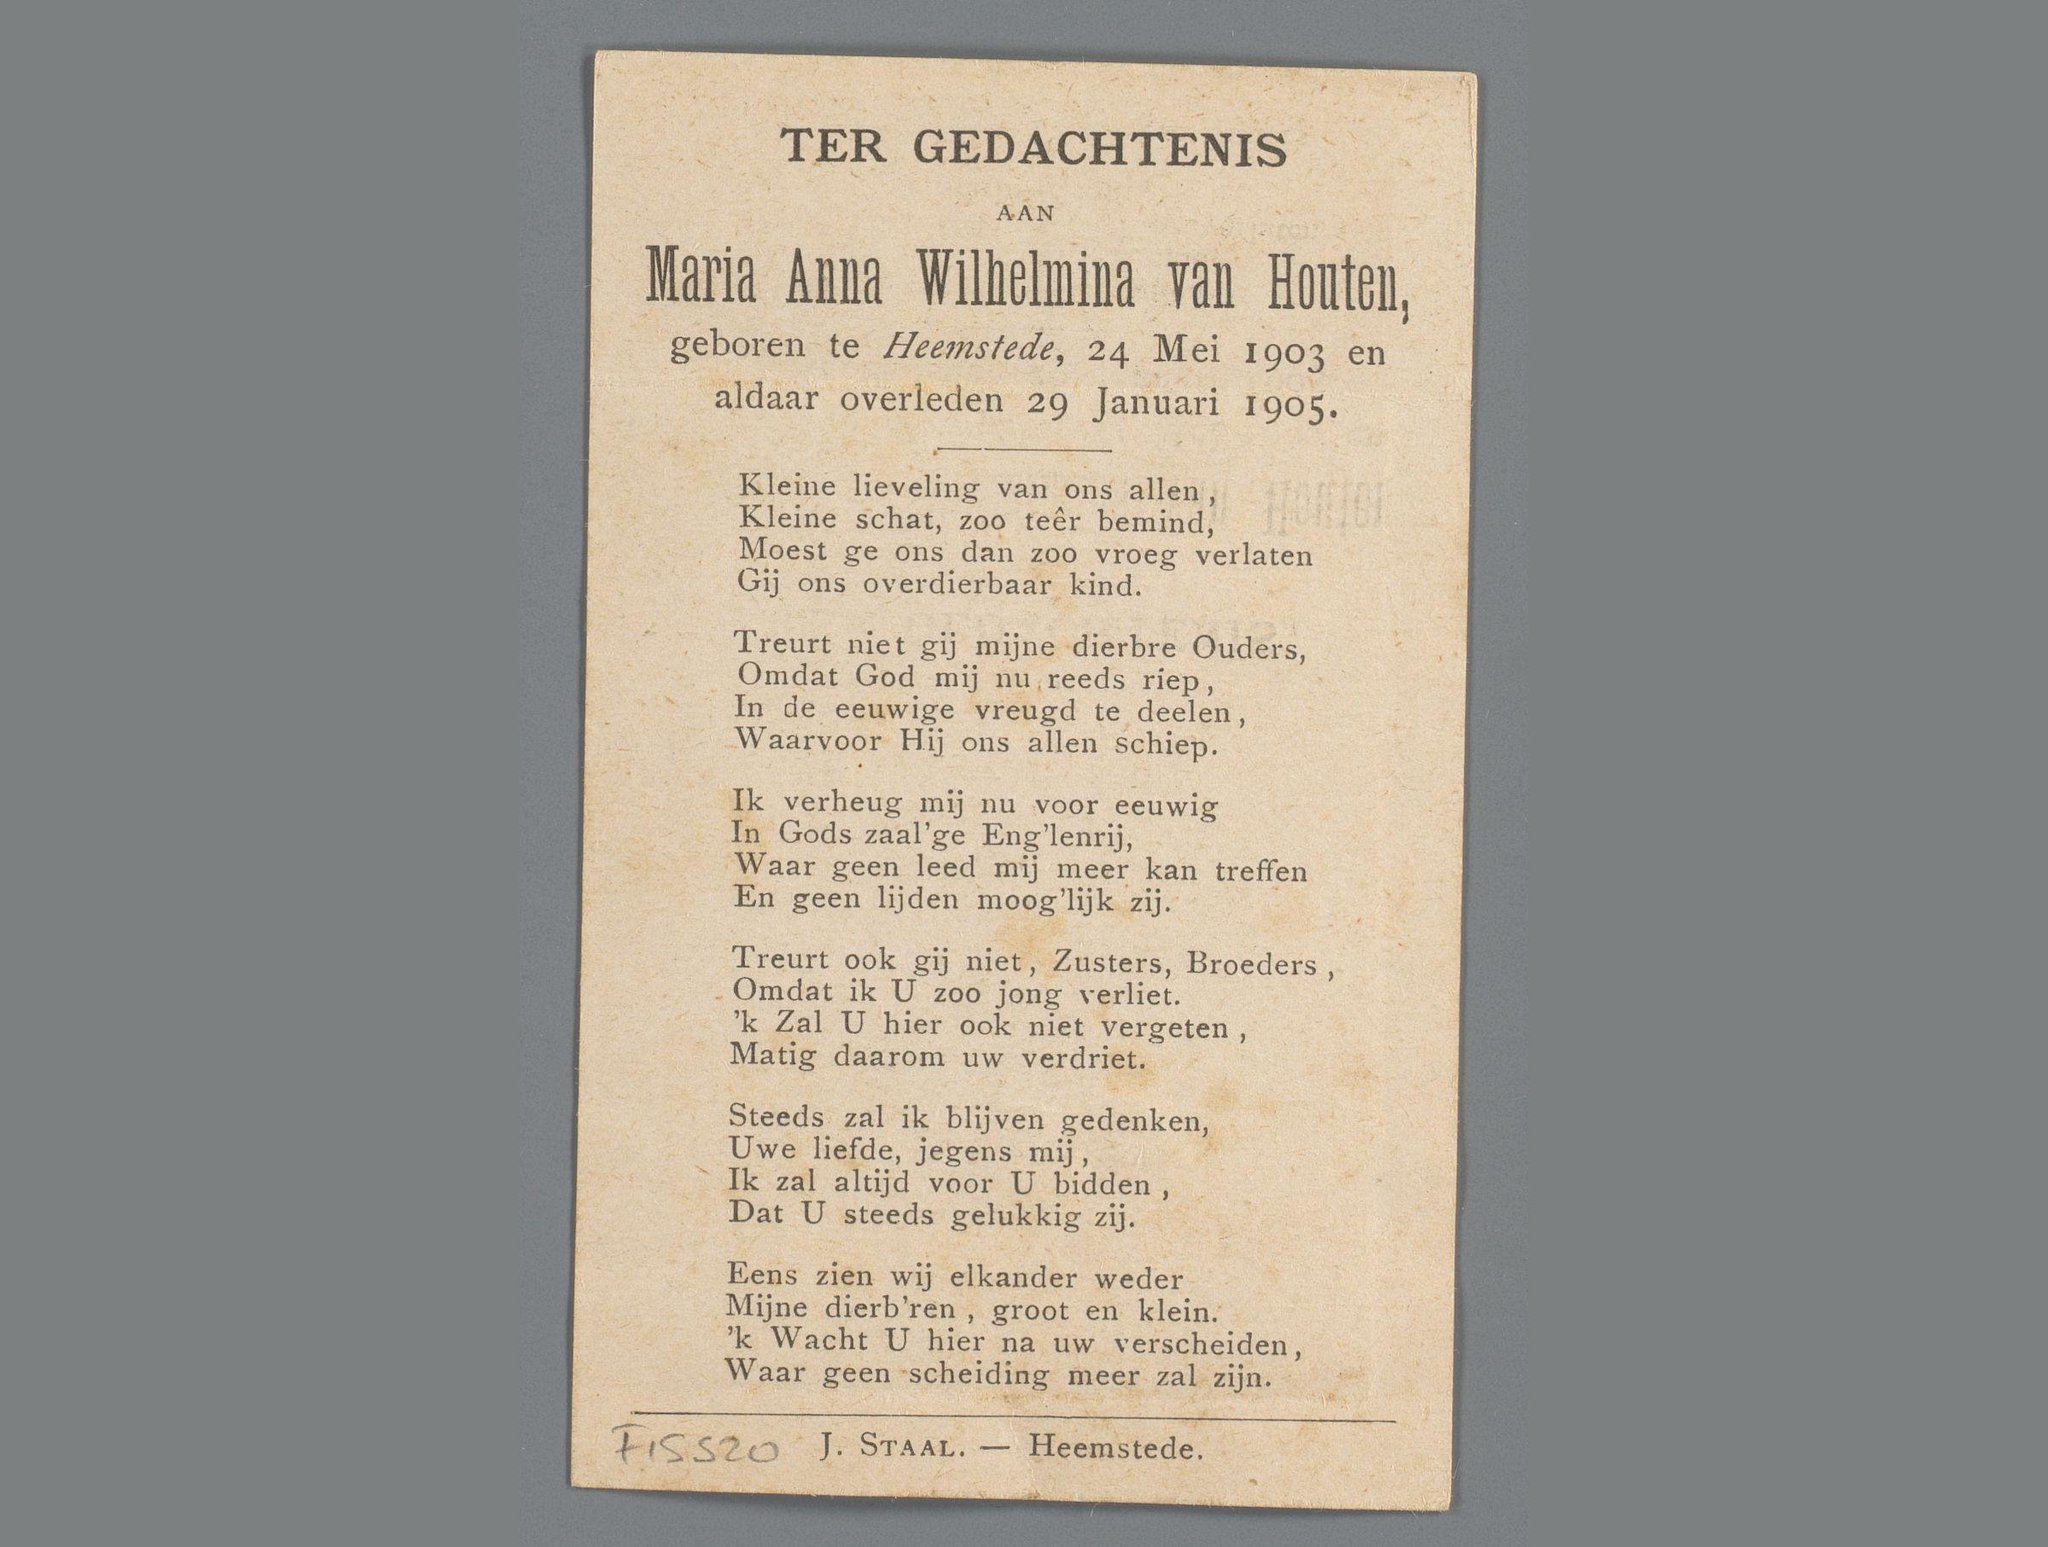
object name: photograph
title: Portret van Maria Anna Wilhelmina van Houten op bidprent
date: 1905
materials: paper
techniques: letterpress printing, lithograph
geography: heemstede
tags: historical persons, infant, baby ~ the ages of man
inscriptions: inscription: ‘Ter gedachtenis (...) Waar geen scheiding meer zal zijn./ J. Staal. - Heemstede.’